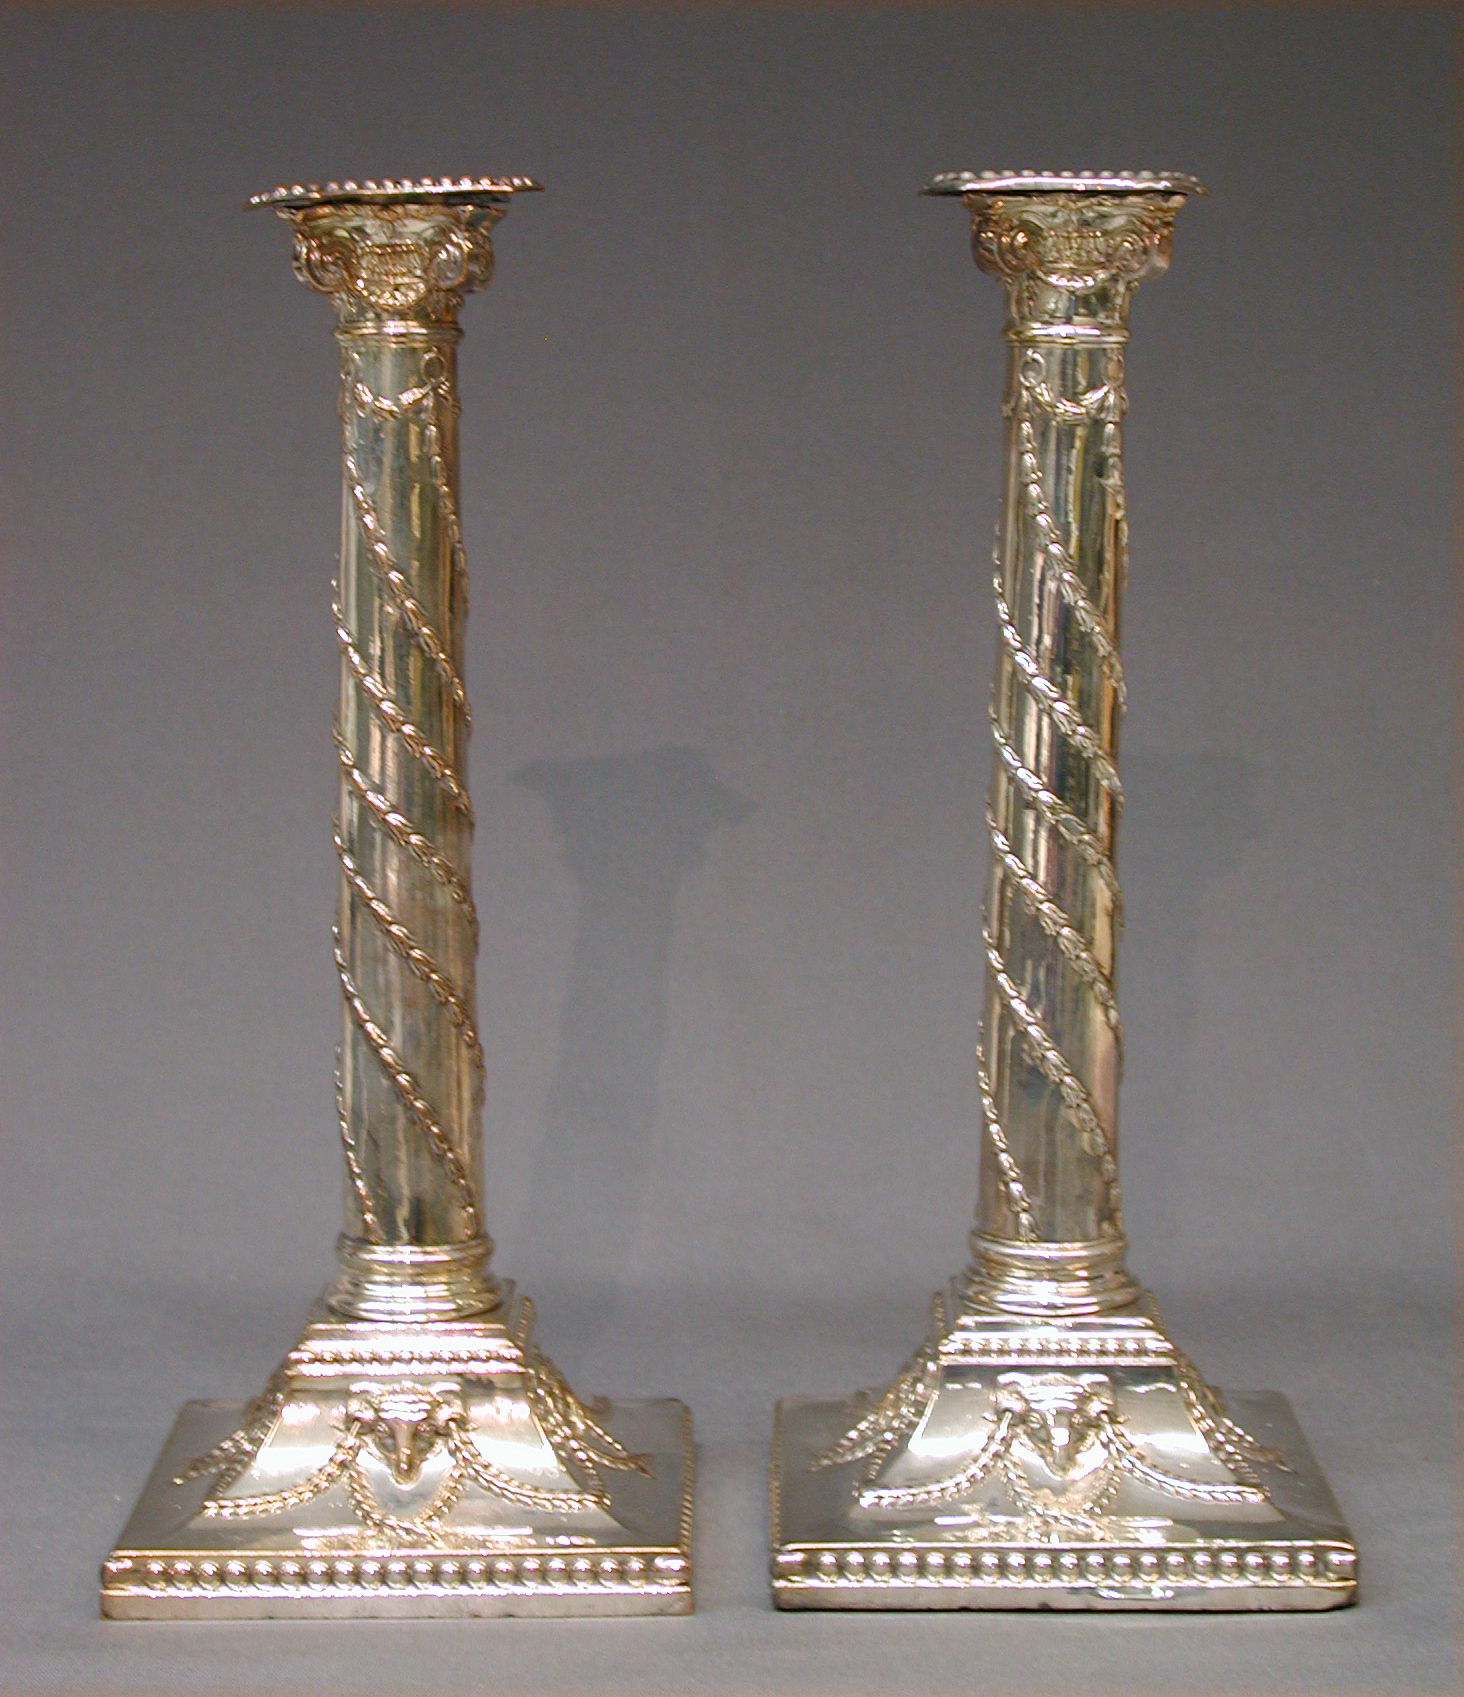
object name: candlestick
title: Pair of candlesticks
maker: tudor and leader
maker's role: maker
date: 1776-1778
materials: metal